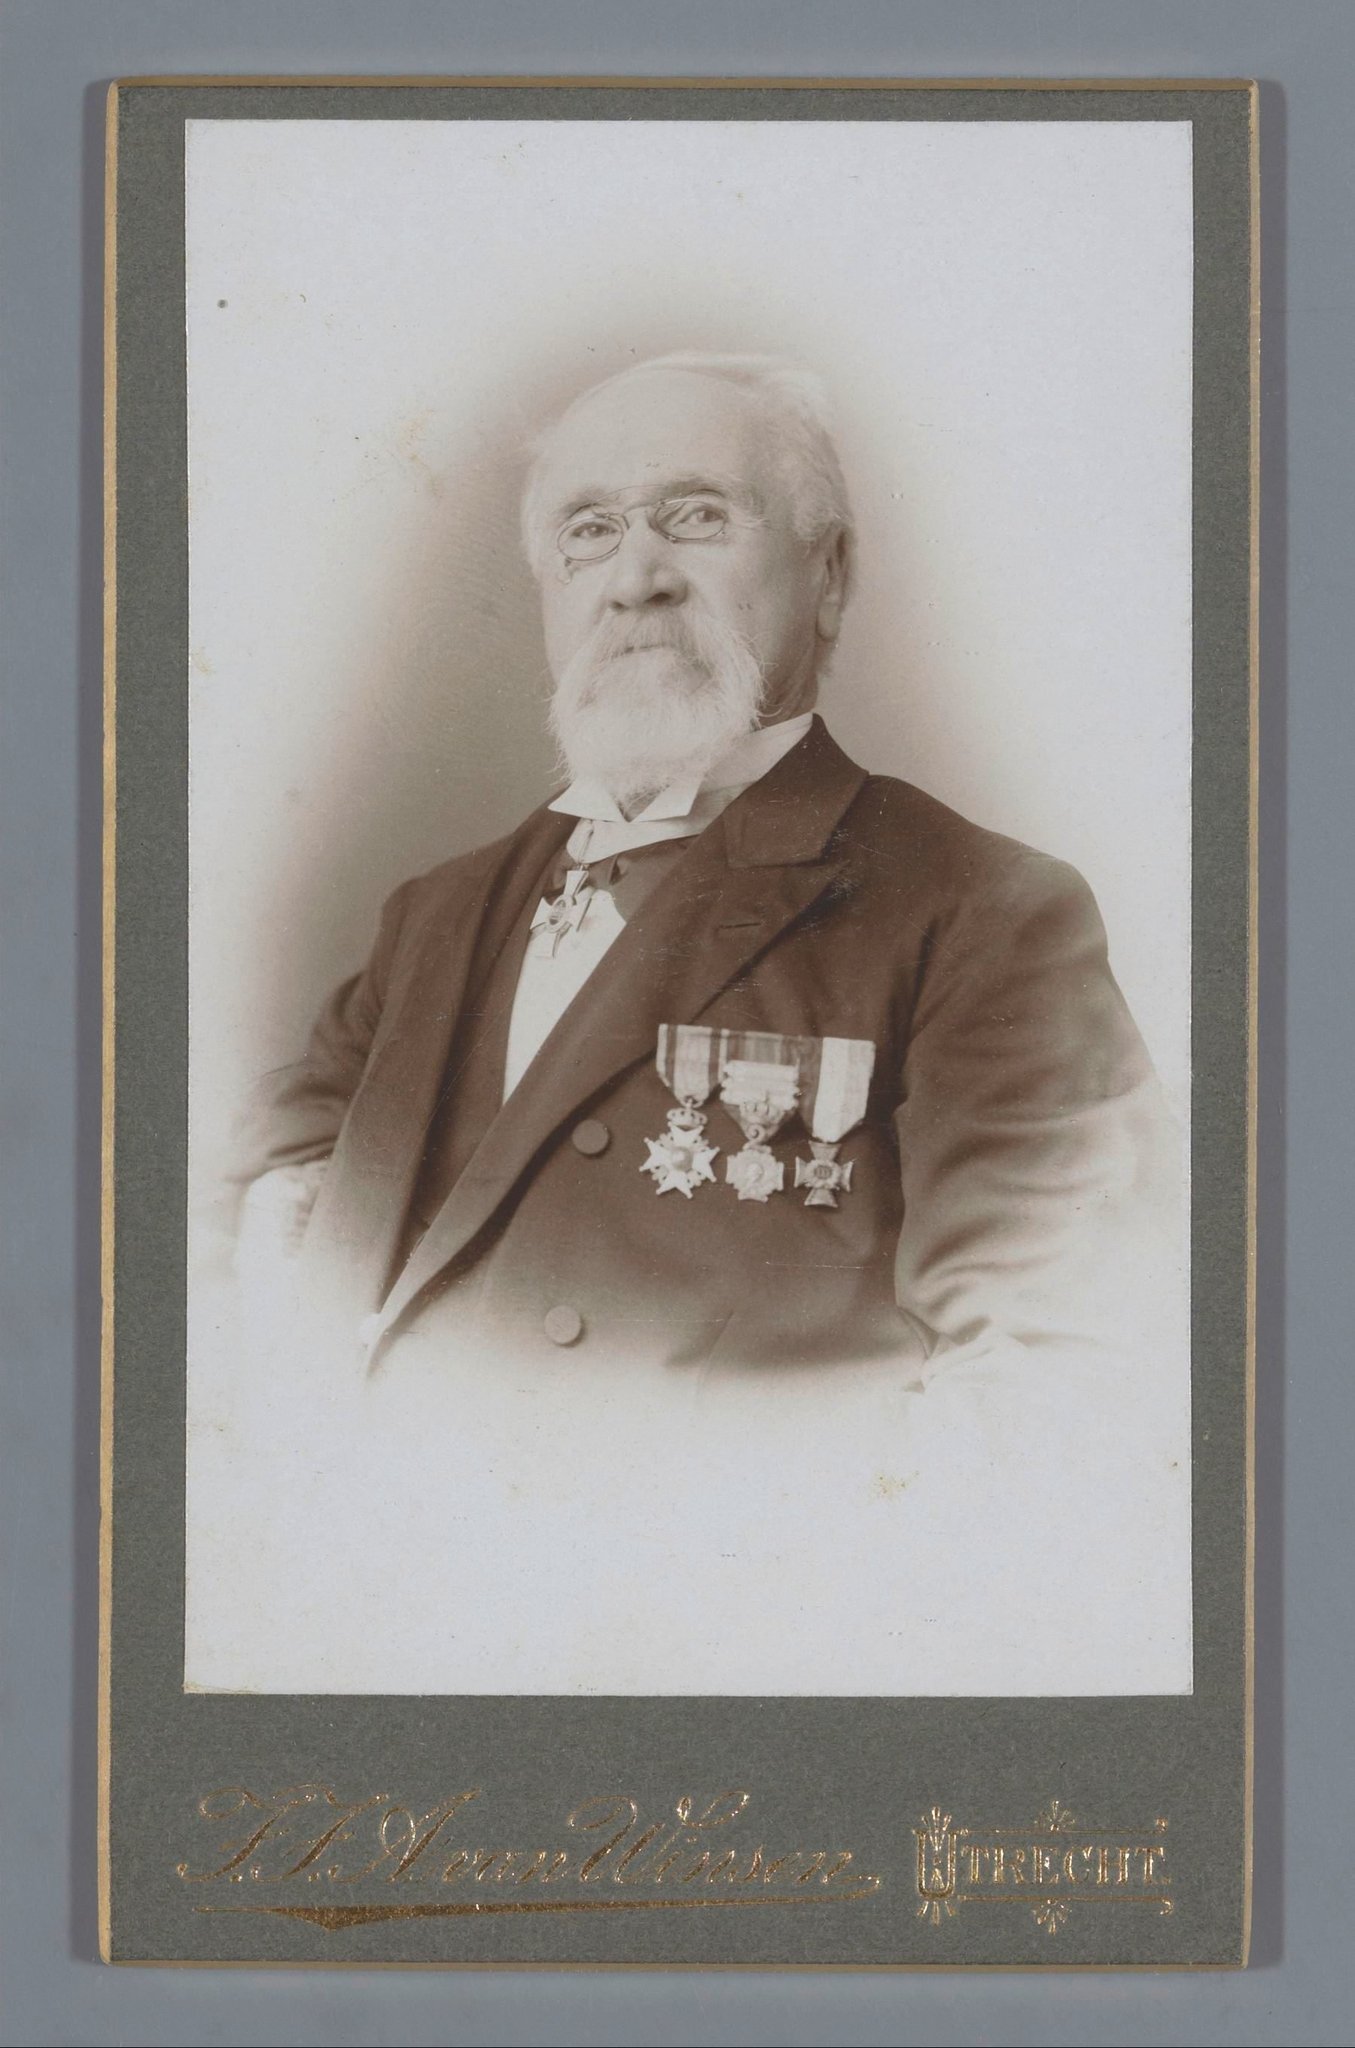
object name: carte de visite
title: Portret van de heer W.F. van Stuyvesant Meyen, gepensioneerd schout bij nacht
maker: jean jacques antoine van winsen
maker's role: fotograaf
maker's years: 1851-1927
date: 1880-1905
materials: cardboard, paper, photographic support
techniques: collodion silver print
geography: utrecht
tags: historical persons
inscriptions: title: ‘25 september 1831 1 juli 1905 W.F. v. Stuyvesant Meyen gep. Schout bij nacht’, signature: ‘J.J. A. van Winsen Utrecht’, signature: ‘Photografisch Artistisch Atelier J.J.A. van Winsen Utrecht, Nieuwe Gracht 75 b/d Zuylenstraat.’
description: Carte-de-visite is onderdeel van een groep portretten aangeboden aan A.J. Nijland, verzamelaar van historieprenten.